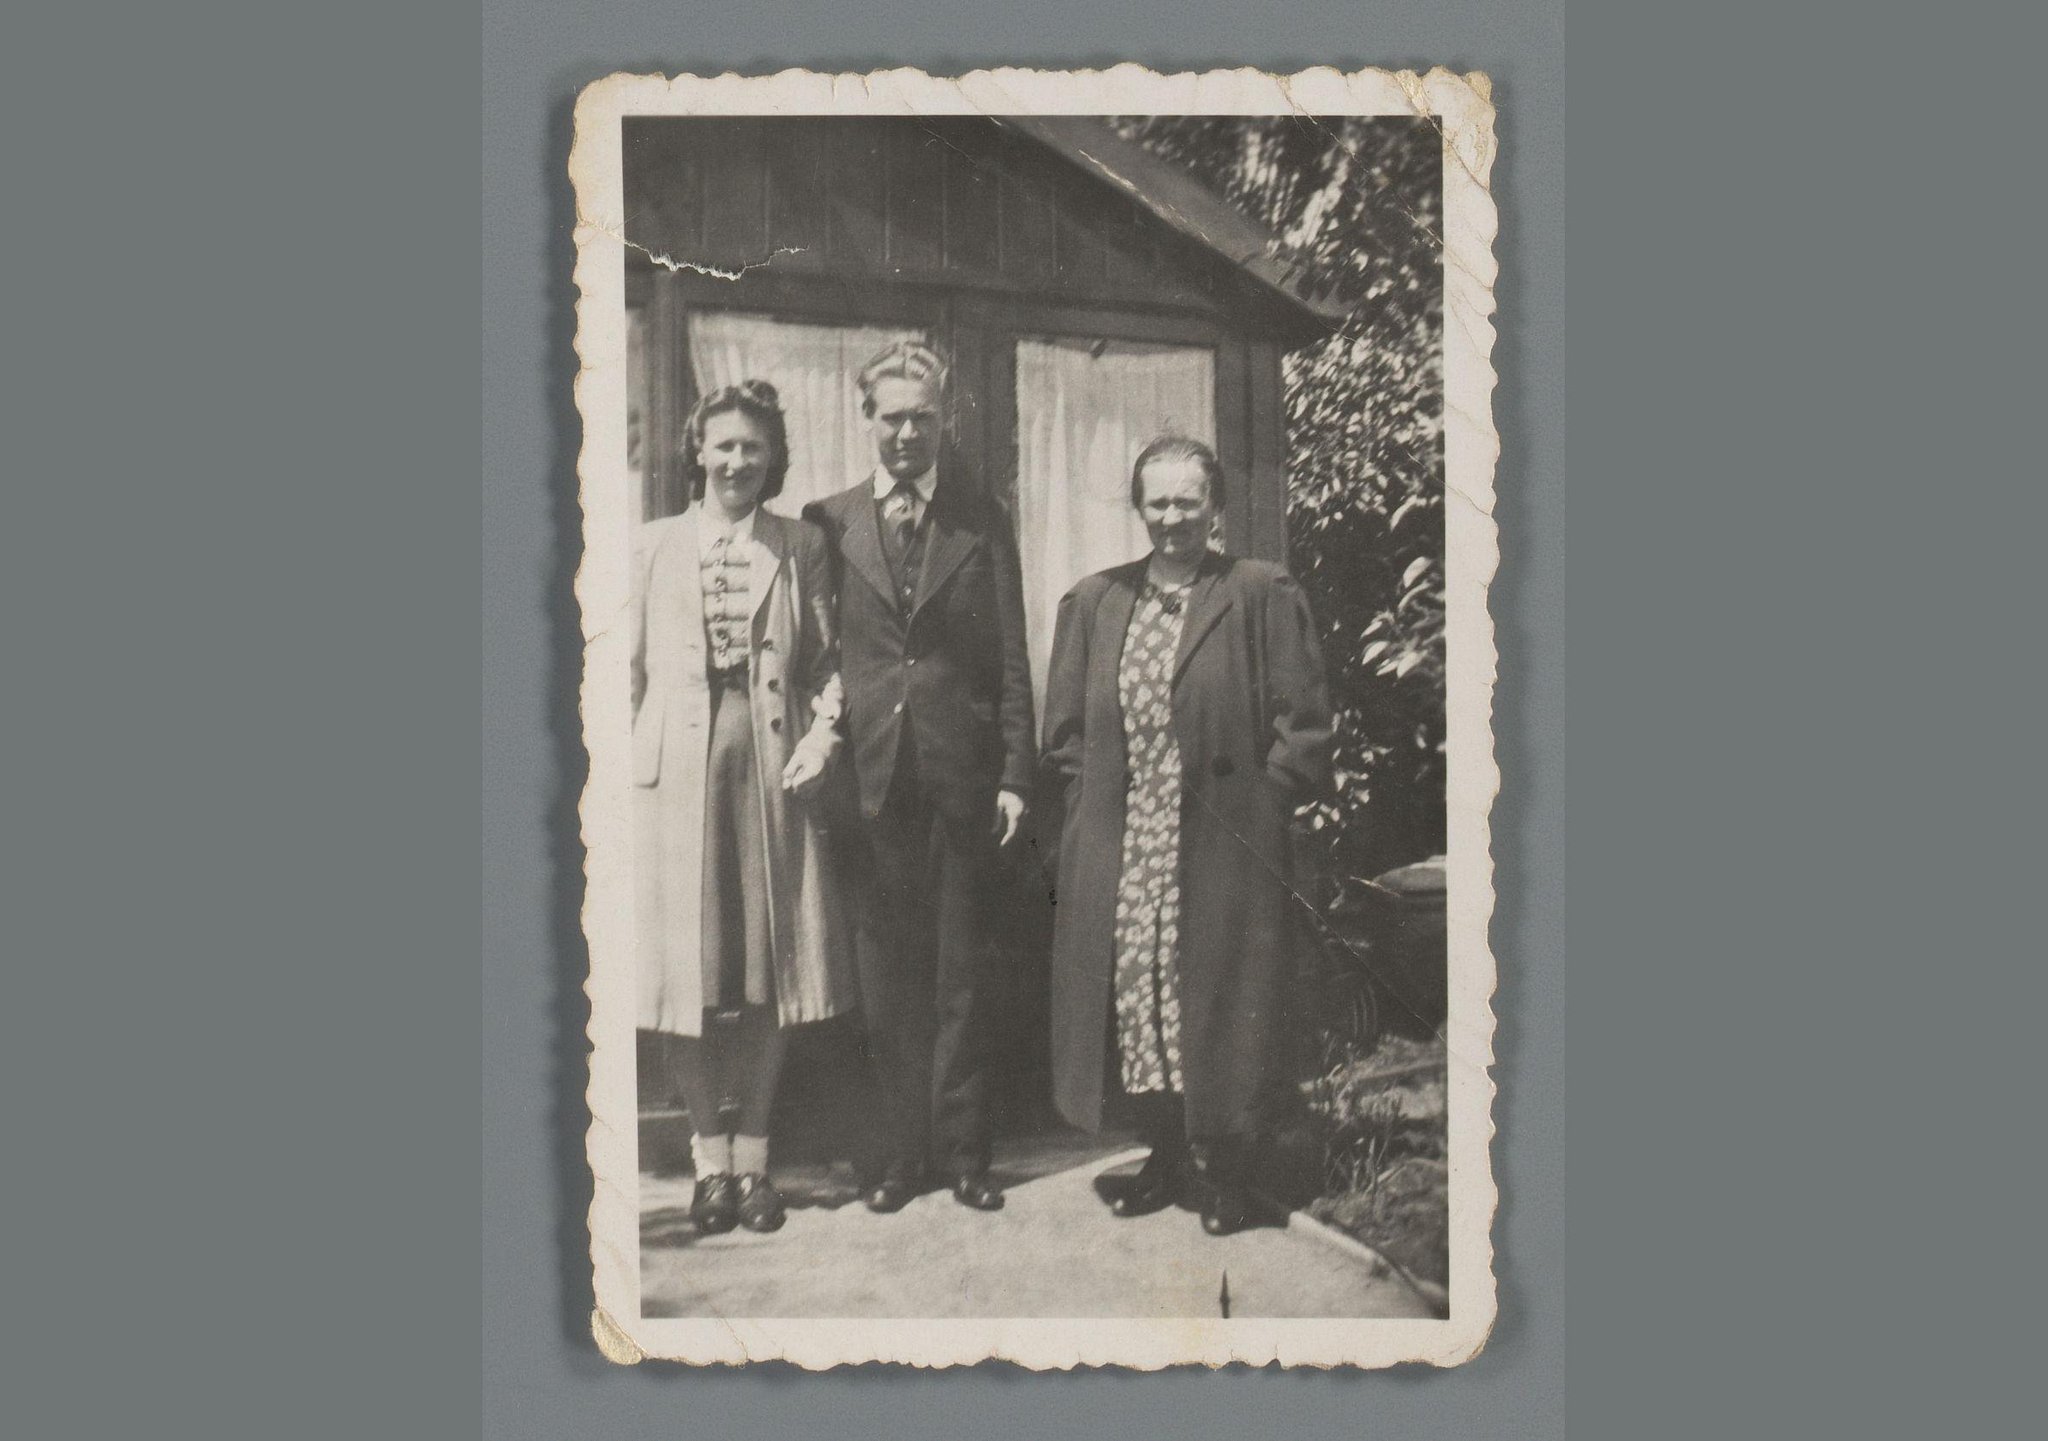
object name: photograph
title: Groepsportret van een onbekende jonge vrouw, jongeman en vrouw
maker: Anonymous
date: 1920-1950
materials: paper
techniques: gelatin silver print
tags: historical persons not known by name